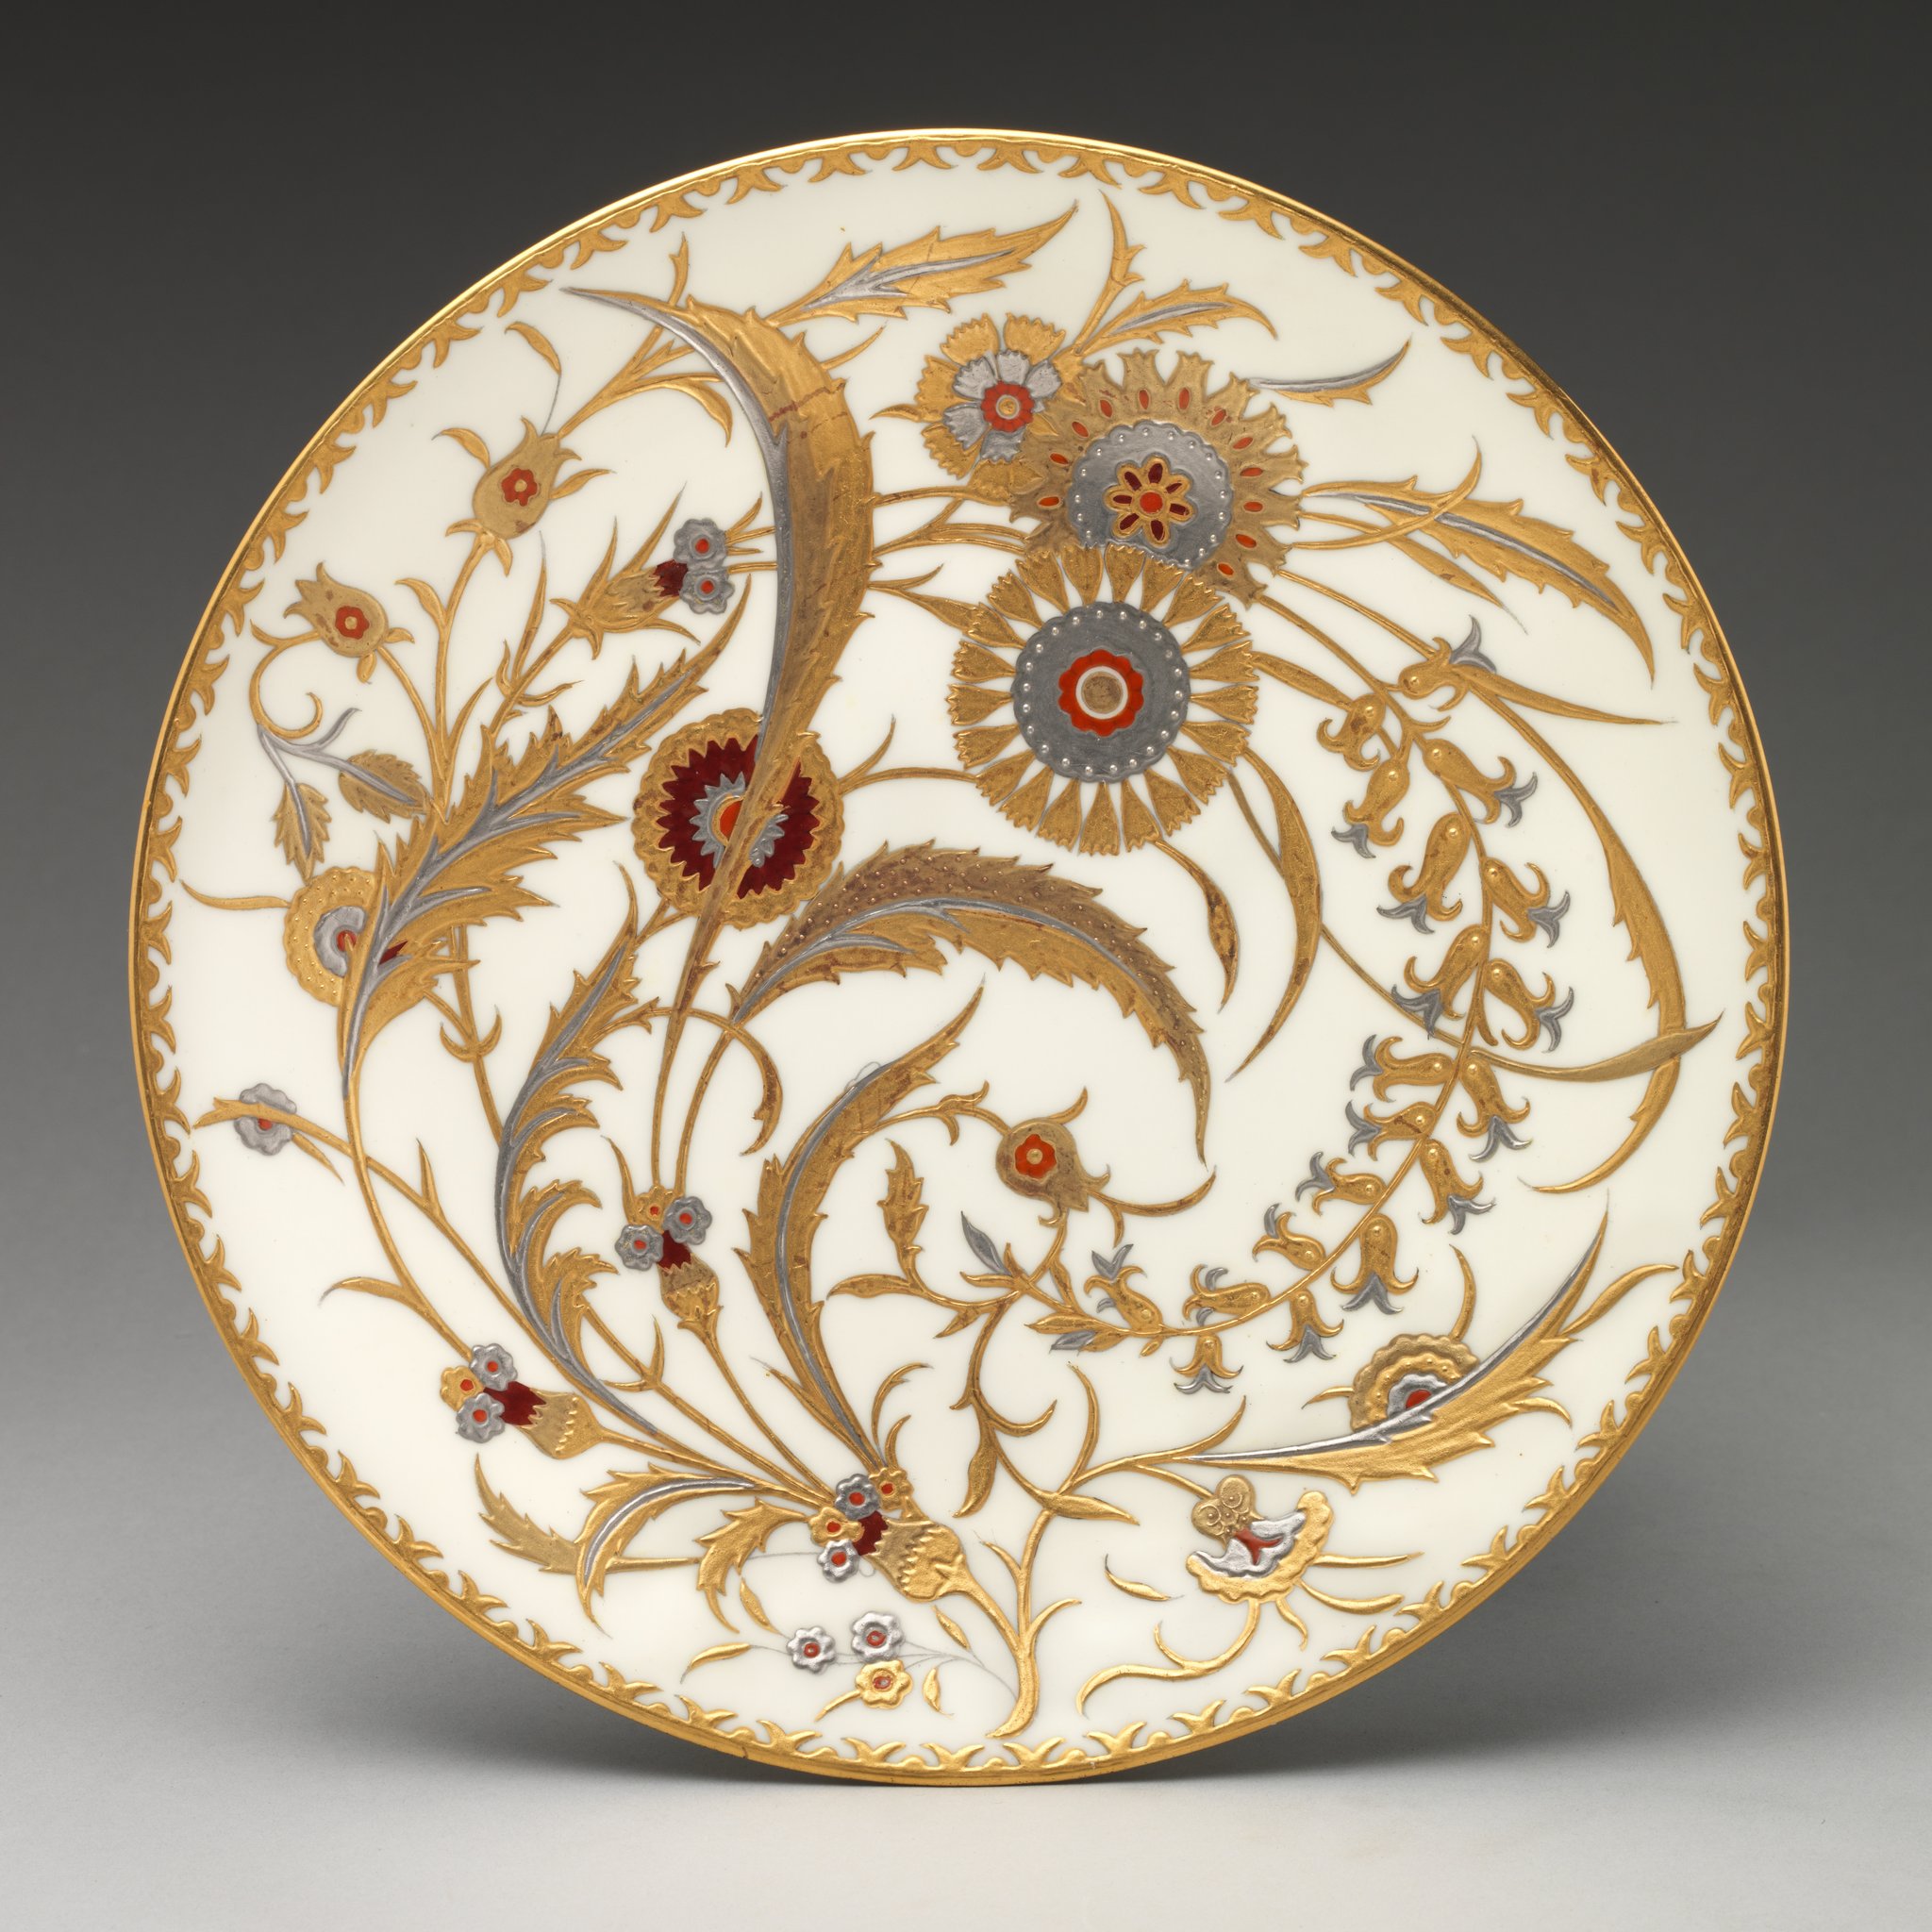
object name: plate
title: Plate with Isnik floral and foliate pattern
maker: minton(s)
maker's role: factory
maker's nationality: british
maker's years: 1793-2001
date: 1881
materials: bone china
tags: flowers